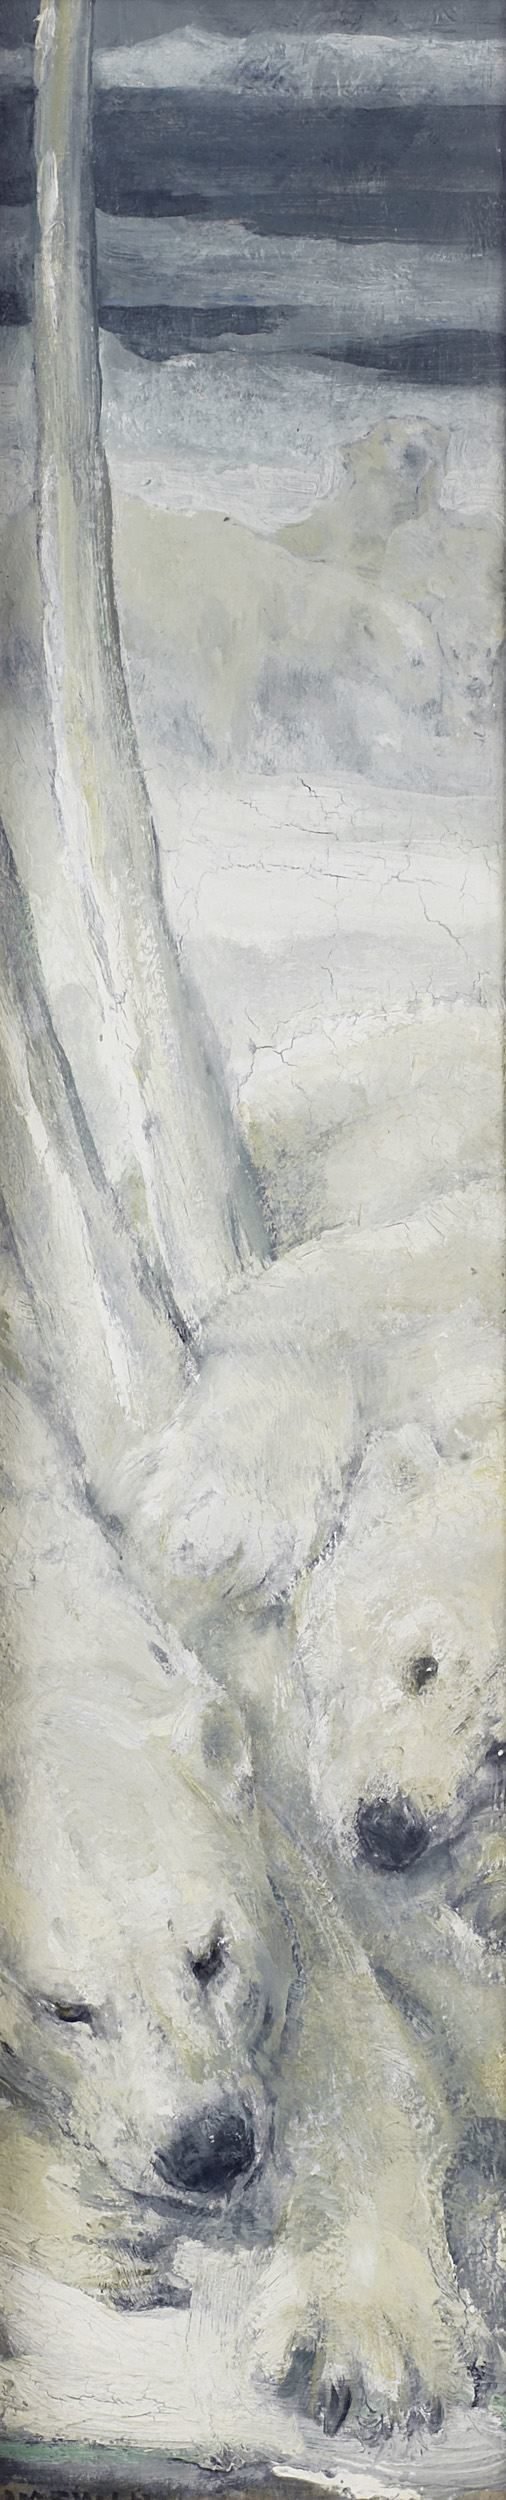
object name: painting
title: Polar Bears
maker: john macallan swan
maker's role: draughtsman, painter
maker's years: 1847-1910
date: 1870-1910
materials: canvas, oil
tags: beasts of prey, predatory animals: polar bear, icefield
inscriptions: signature: ‘JMSwan’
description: Studie met ijsberen in een poollandschap.